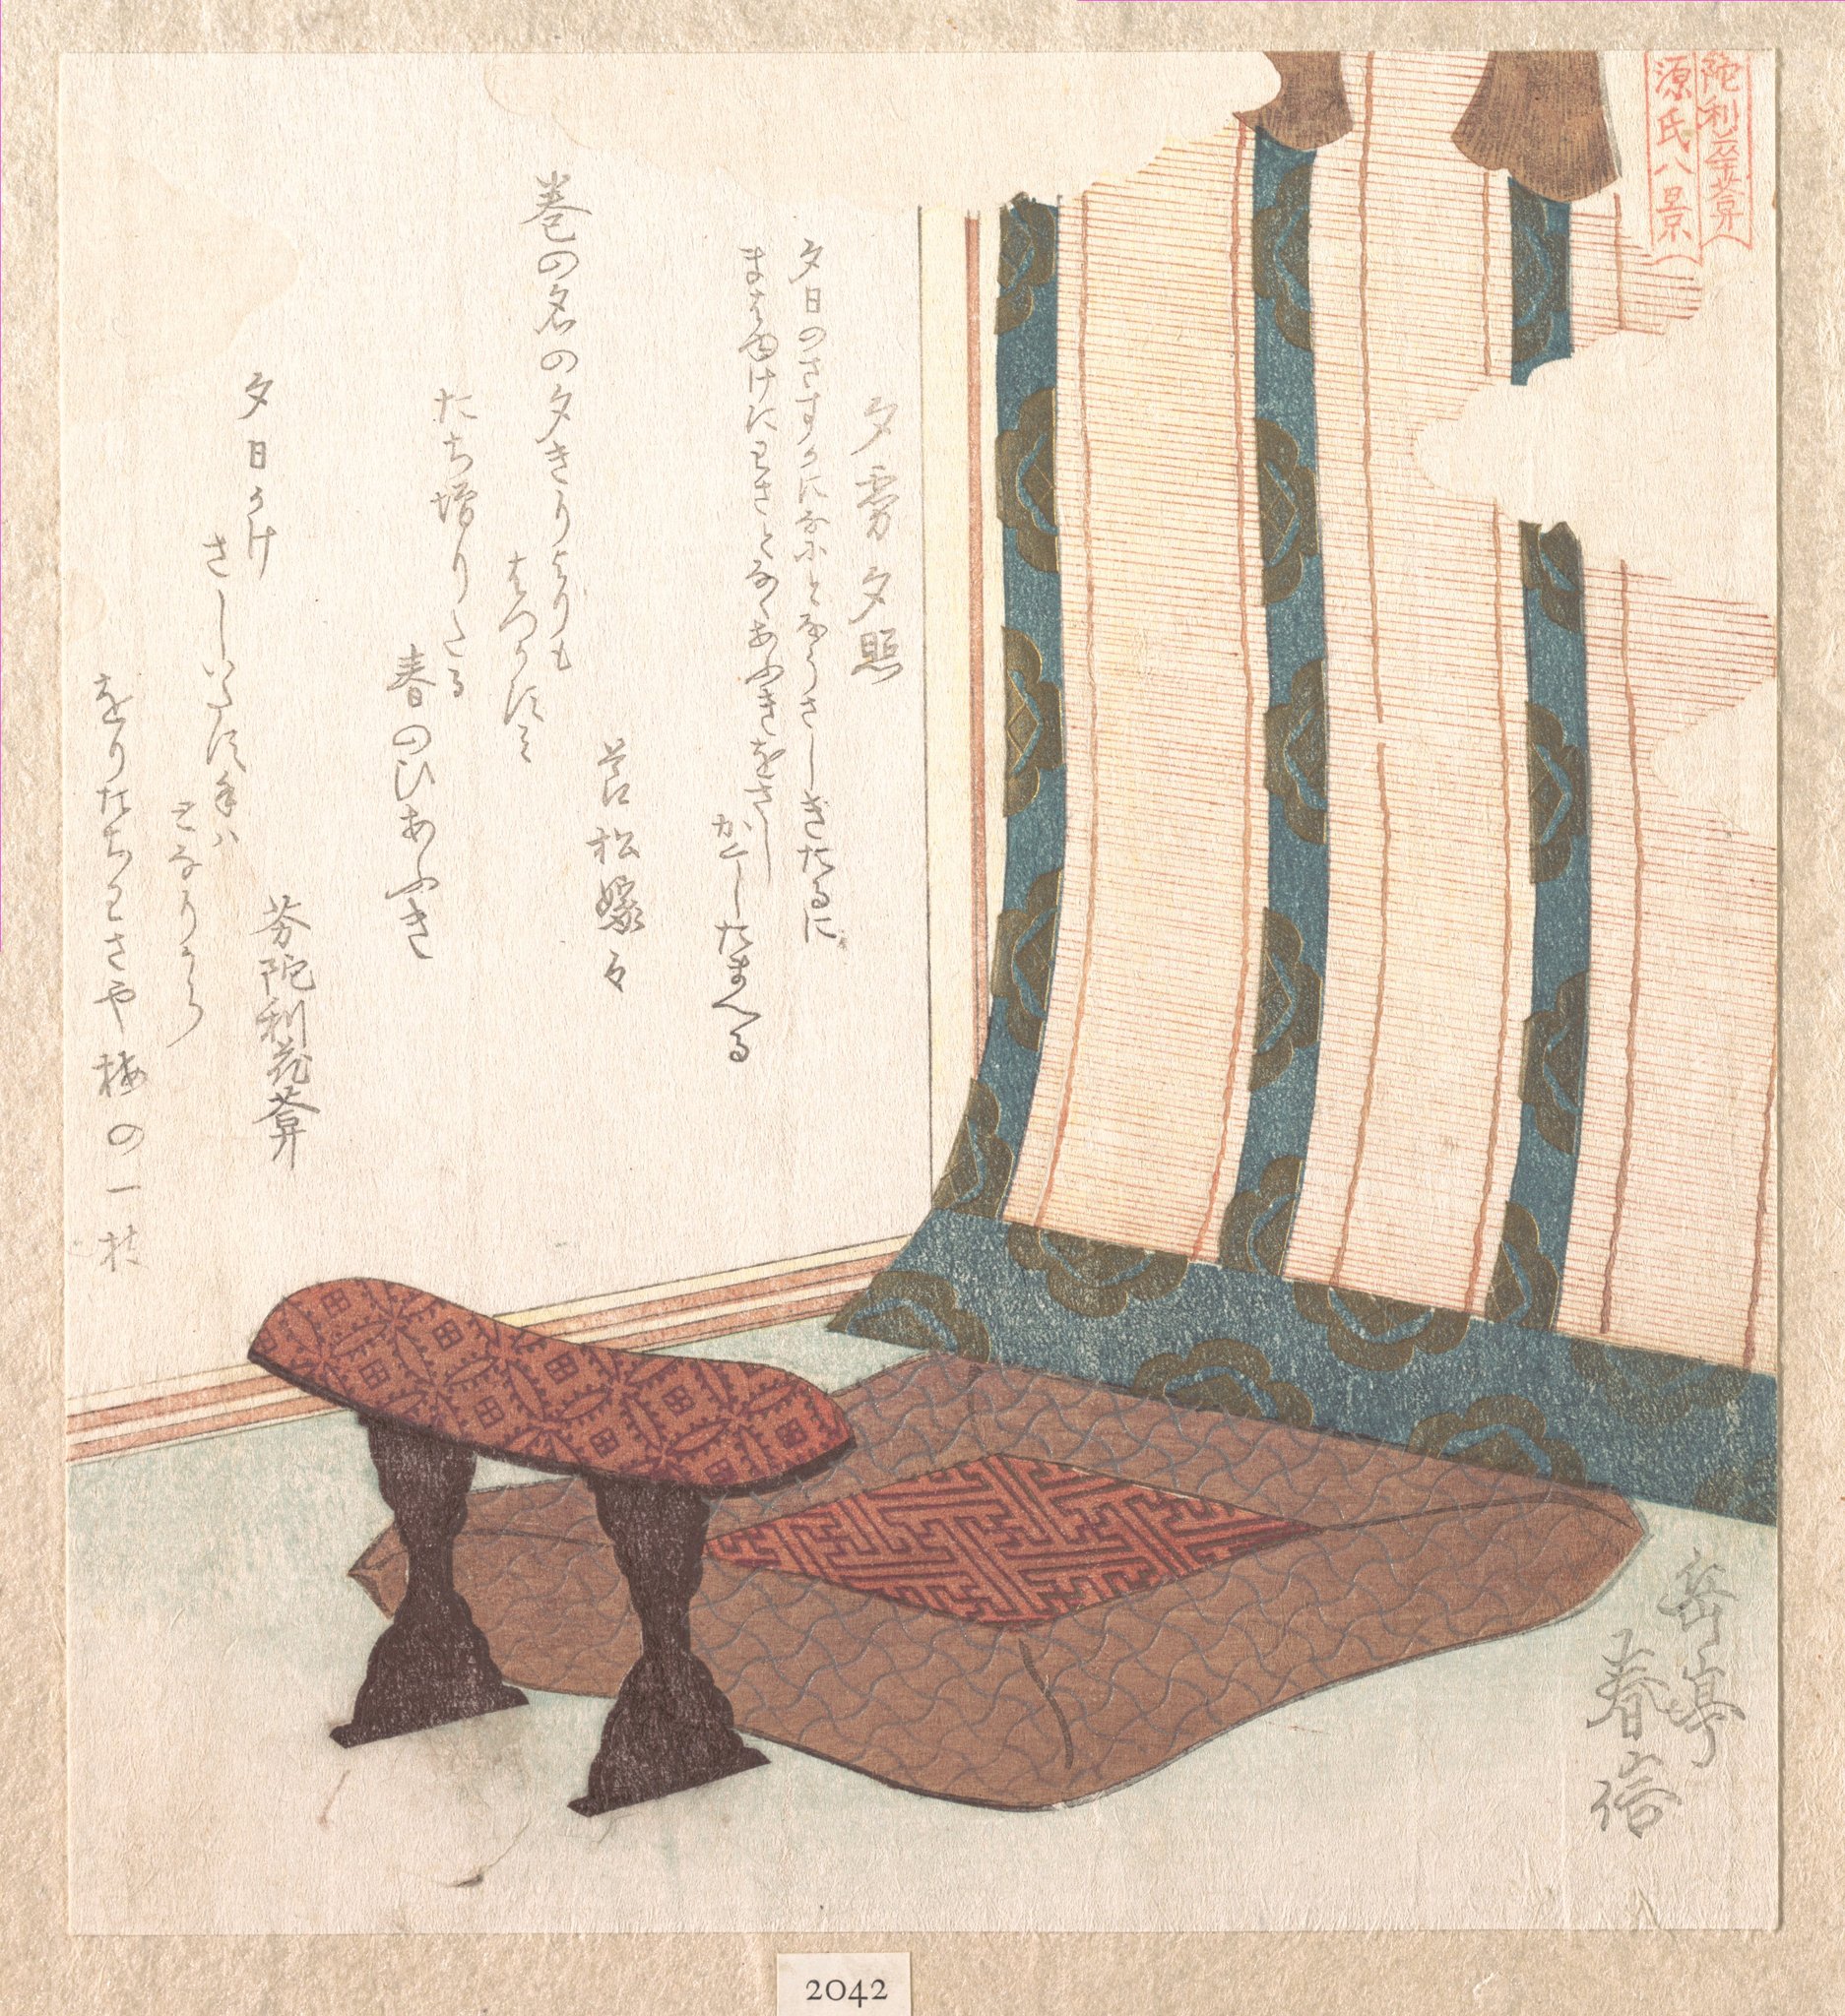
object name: print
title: Eight Views of the Genji Story: Still Life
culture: japanese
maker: yashima gakutei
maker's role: artist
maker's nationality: japanese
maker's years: 1786-1868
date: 1801-1900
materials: ink, paper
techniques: surimono, woodblock print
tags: still life